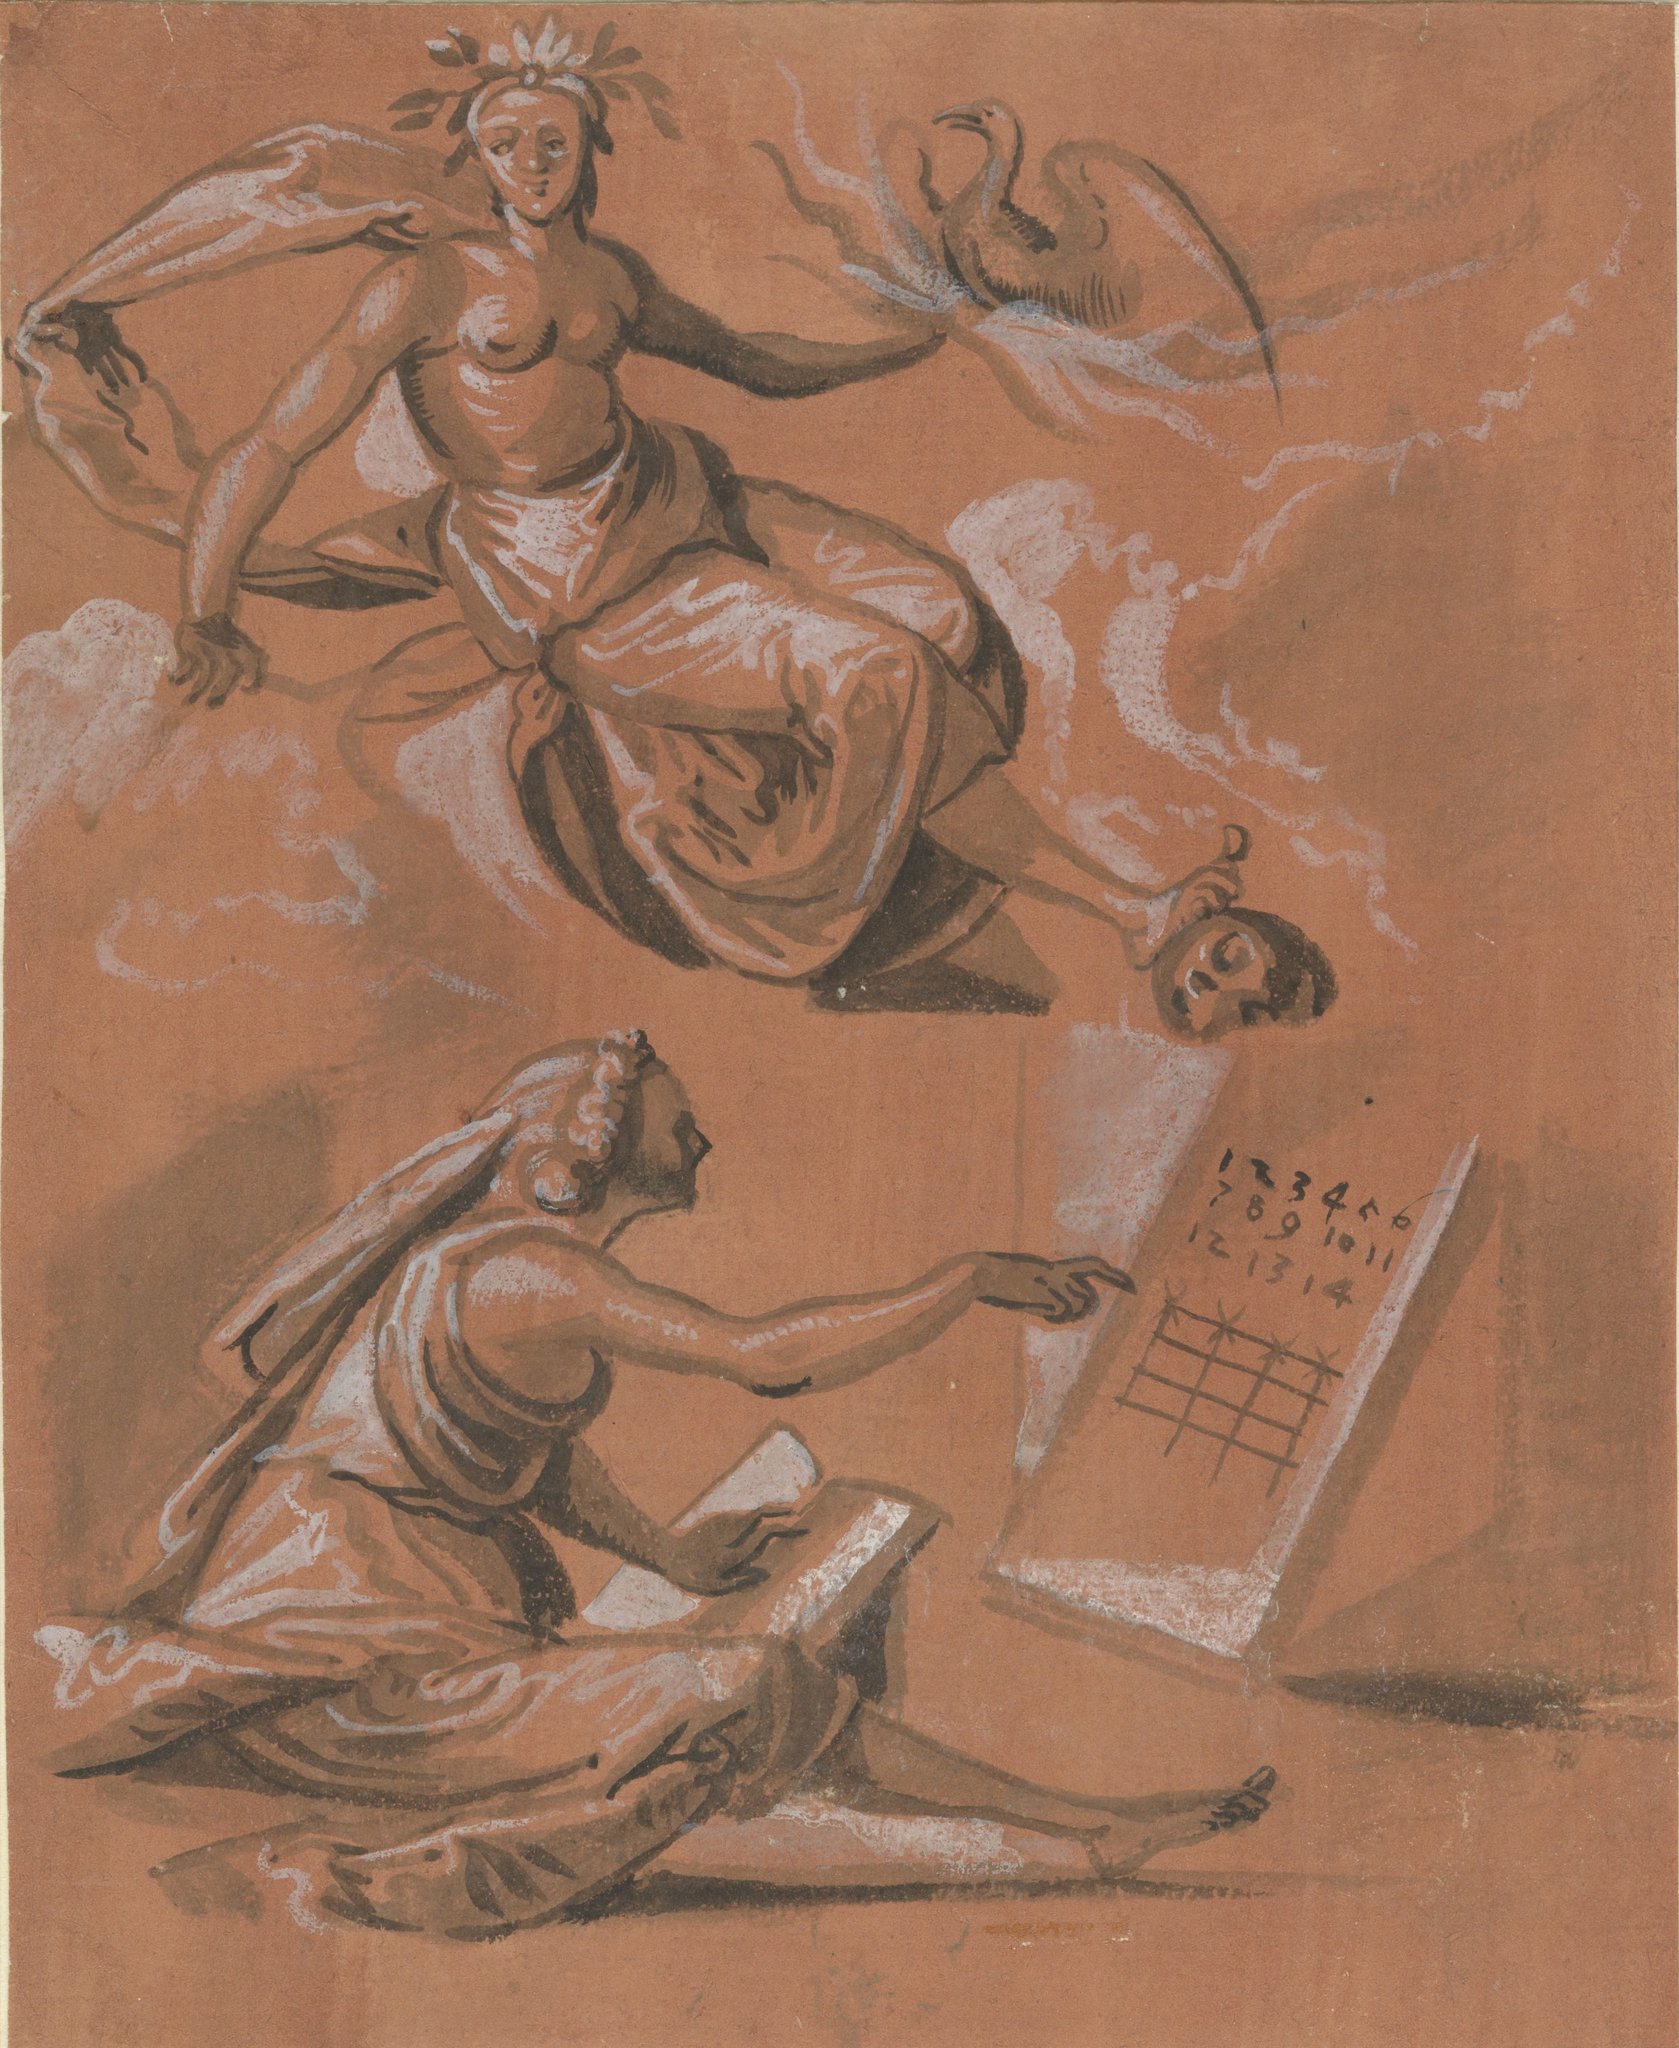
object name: drawing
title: Faam en Arithmetica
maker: Anonymous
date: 1550-1599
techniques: brush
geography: southern germany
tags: 'arithmetica' (~ quadrivium); 'aritmetica' (ripa), fame; 'fama', 'fama buona', 'fama chiara' (ripa)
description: Twee godinnen, personificaties van de Faam en de Arithmetica.